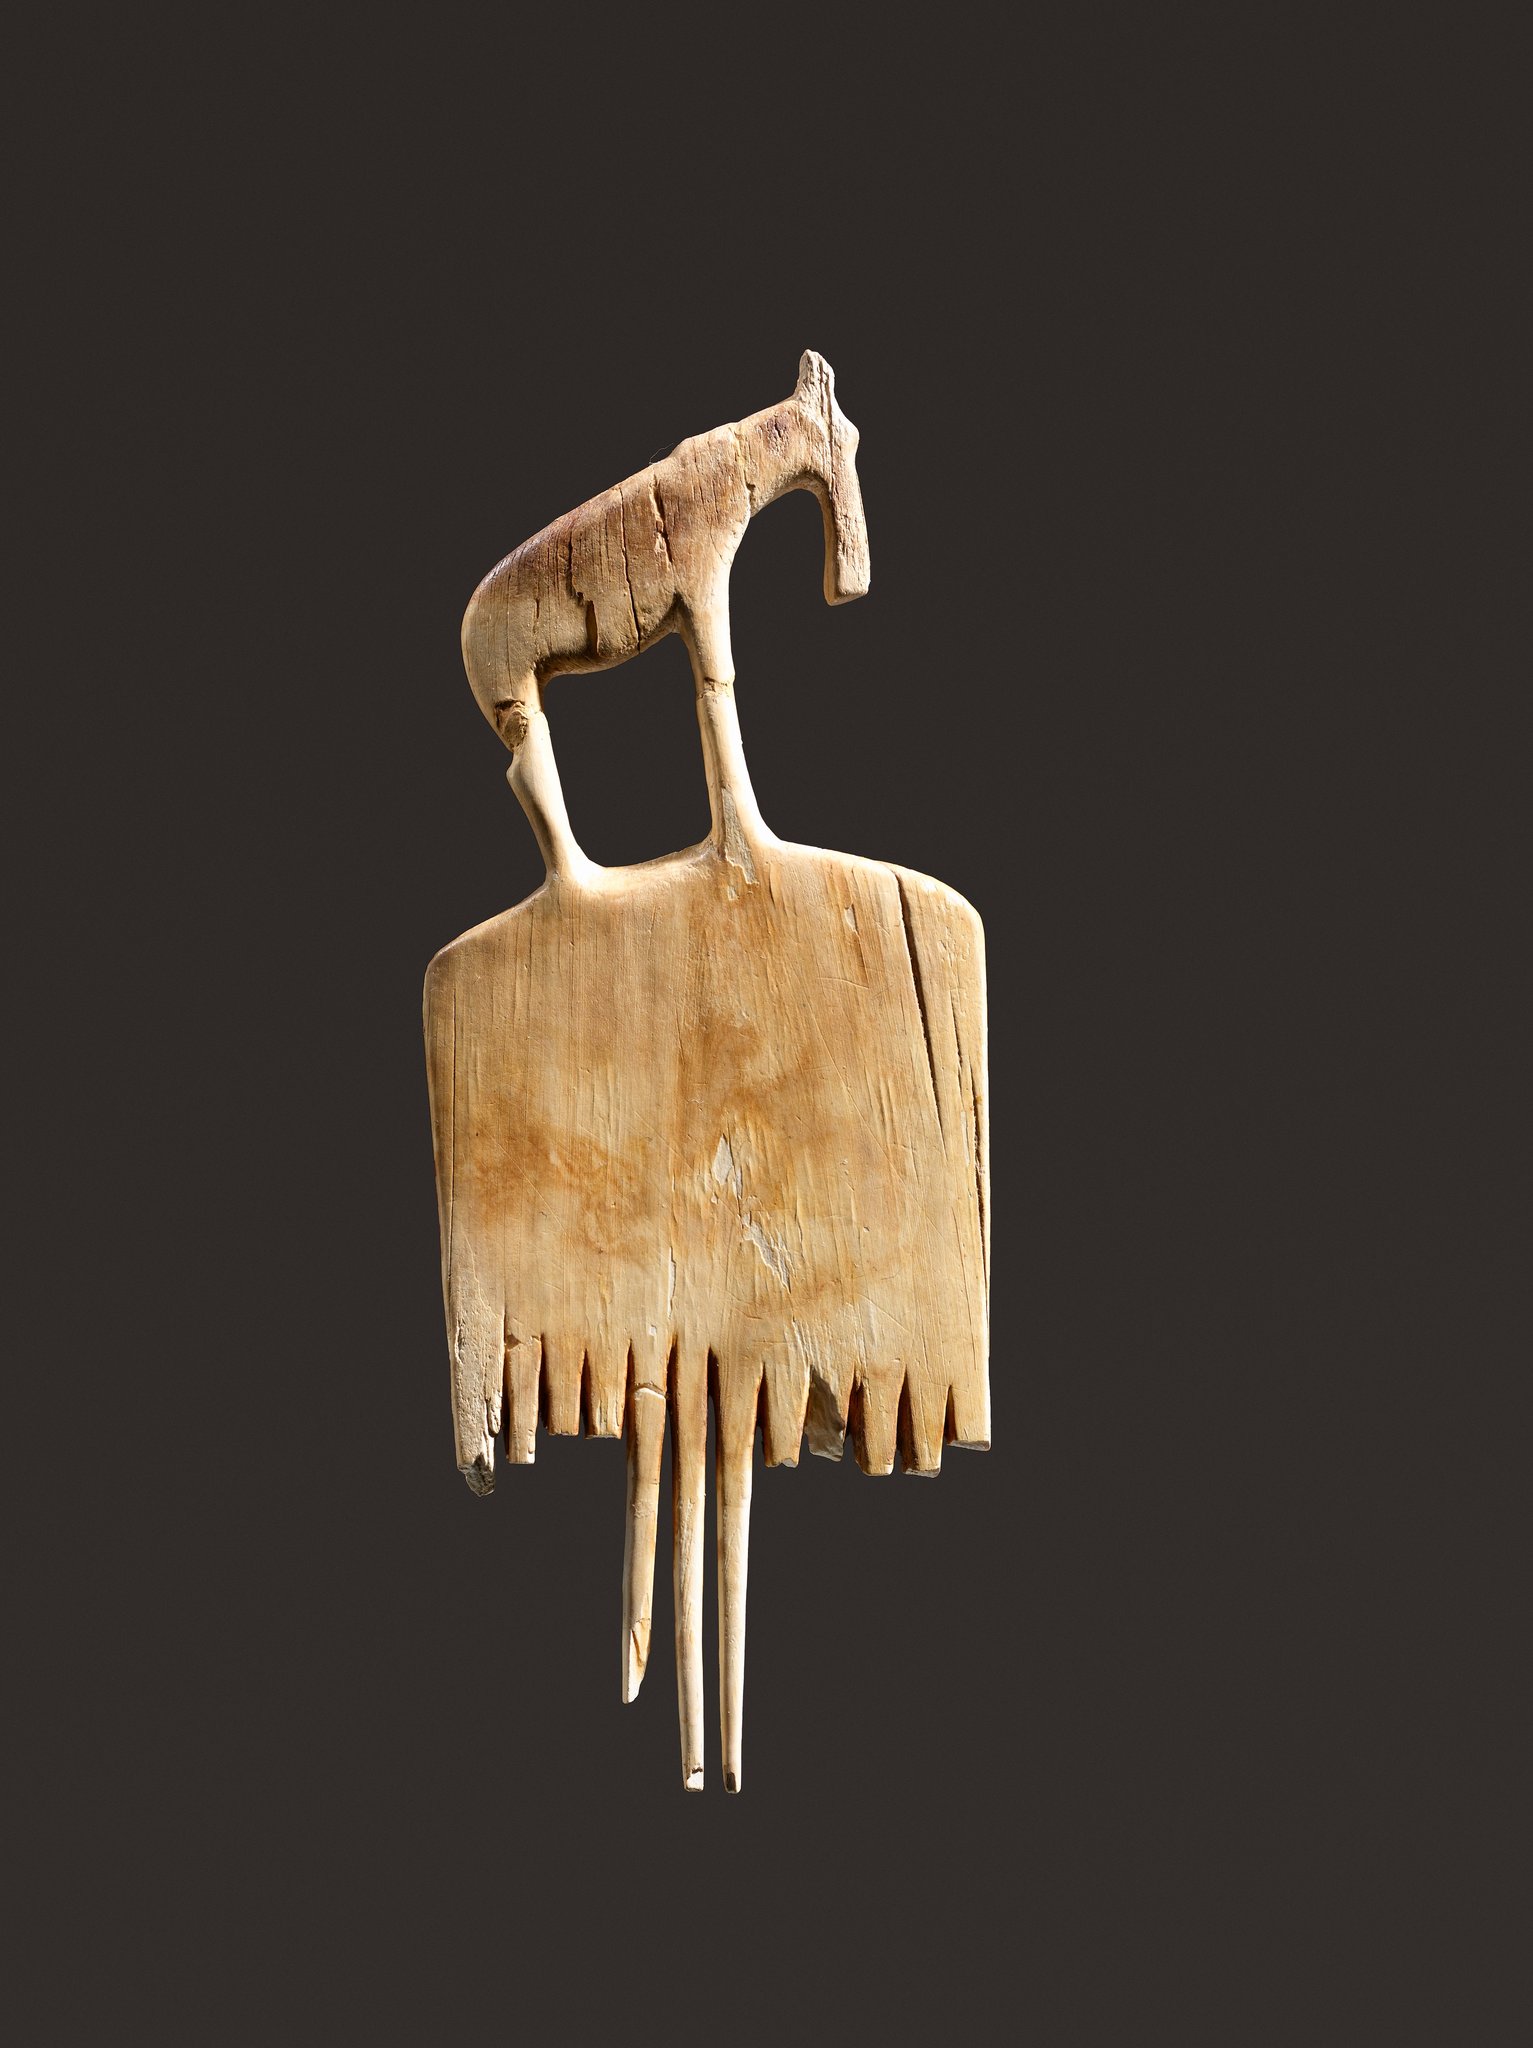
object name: comb, wildebeast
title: Comb decorated with a wildebeest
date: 3900-3500 BCE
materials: ivory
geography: egypt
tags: animals